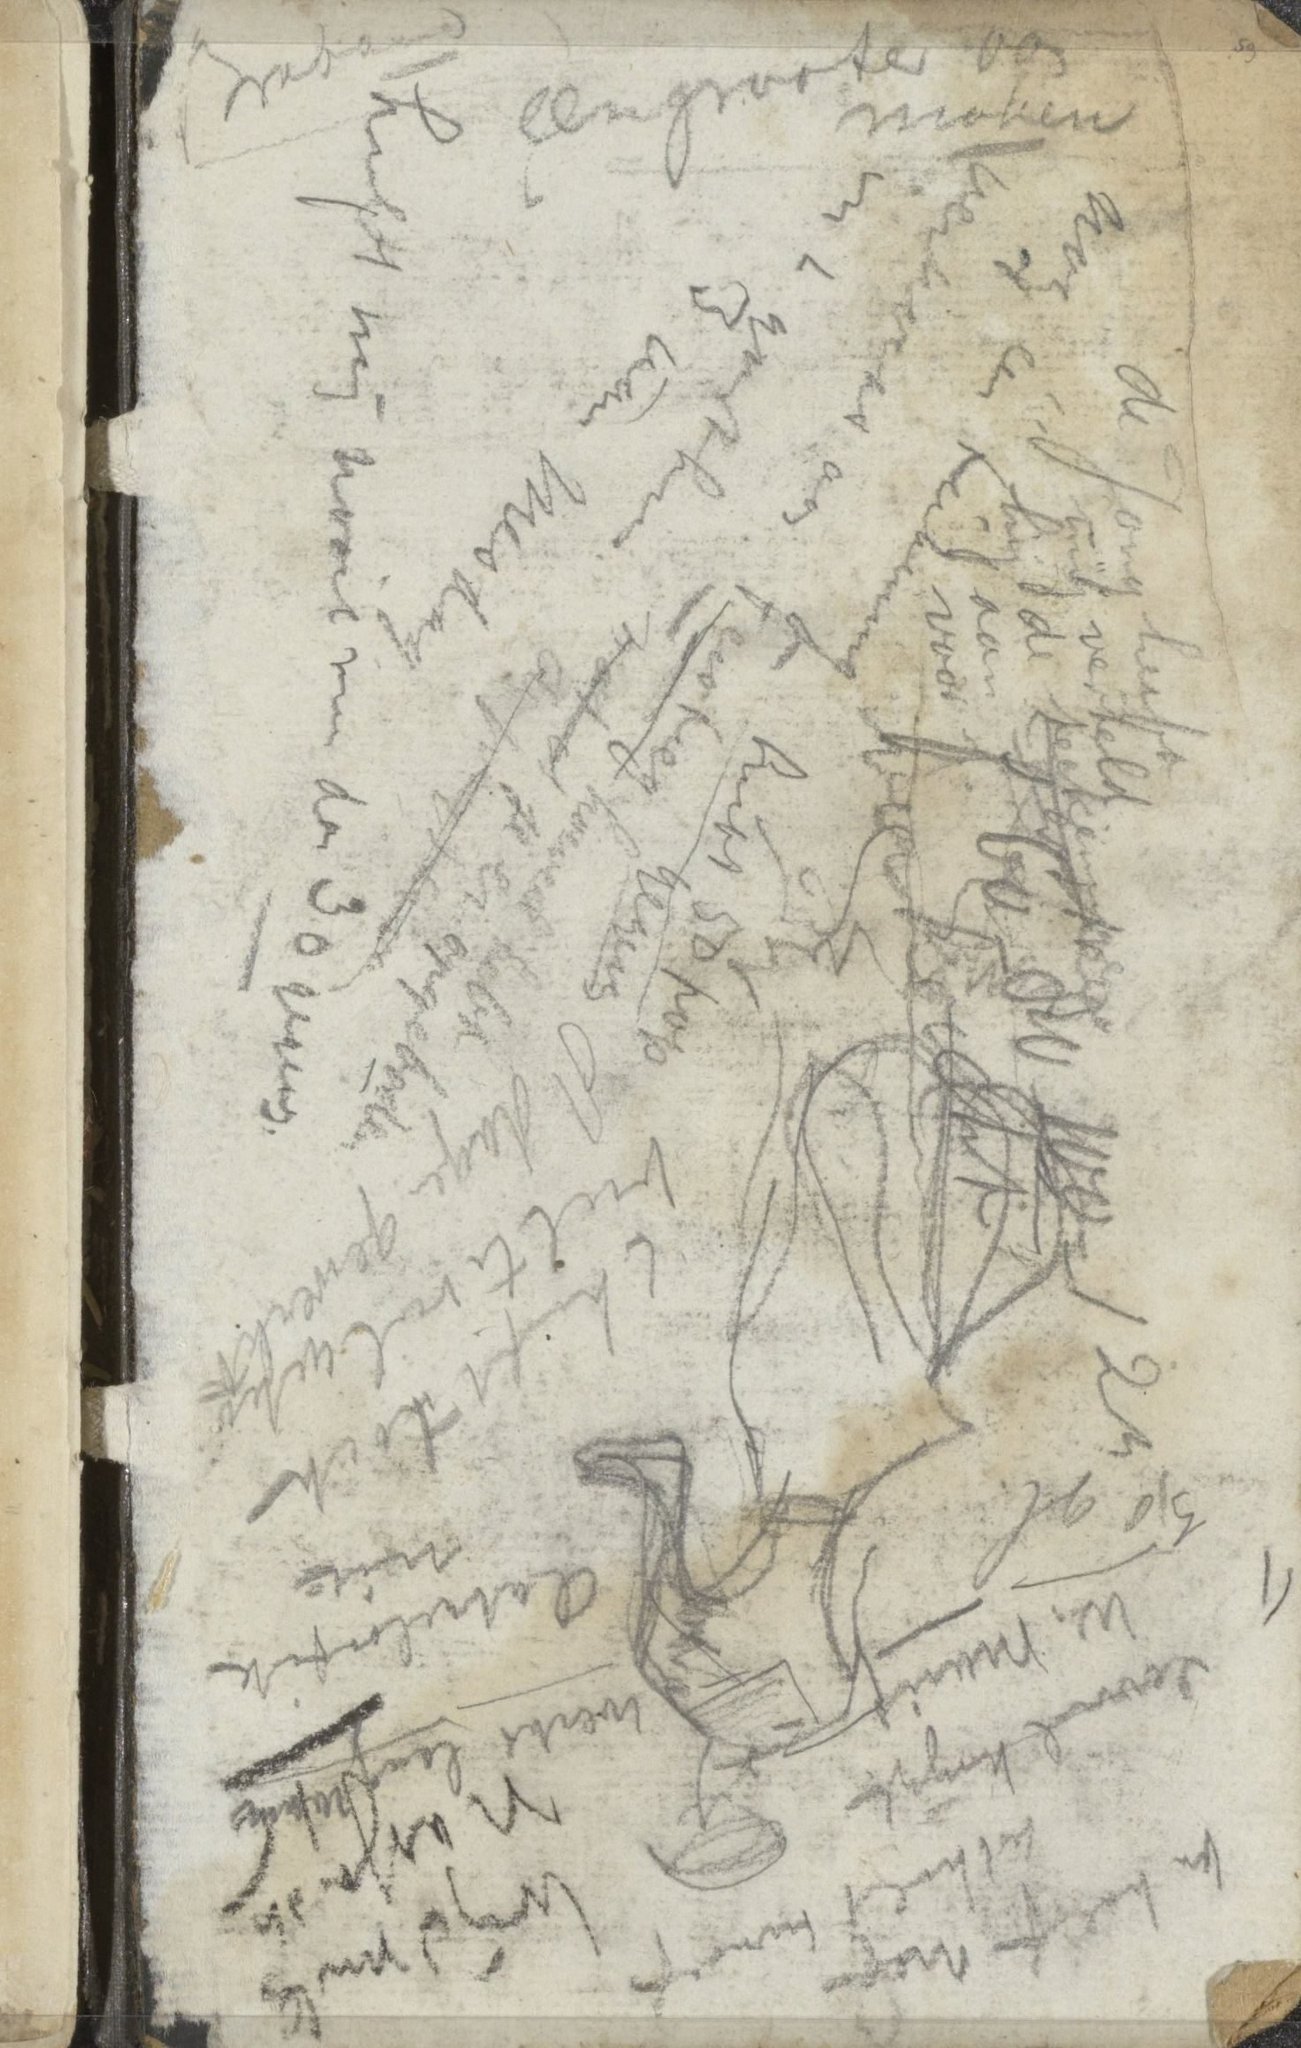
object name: sketchbook leaf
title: Vrouw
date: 1881-1883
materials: chalk, paper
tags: adult woman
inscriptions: annotation: ‘[...] werkt langzaam/ [...]/ (heeft toch veel te veel [...]/ 8 dagen gewerkt/ [...] de Jong heeft/ mij verteld/ hij de teekening[...]/ aan/ voor [...] verkocht/ nog één teekening/ verkocht aan Tersteeg/ hoeveel heb/ je er op geboden/ in t gasthuis/ 3 [...] Mesdag’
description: Pagina 59, achterste schutblad, uit een schetsboek met 29 bladen.